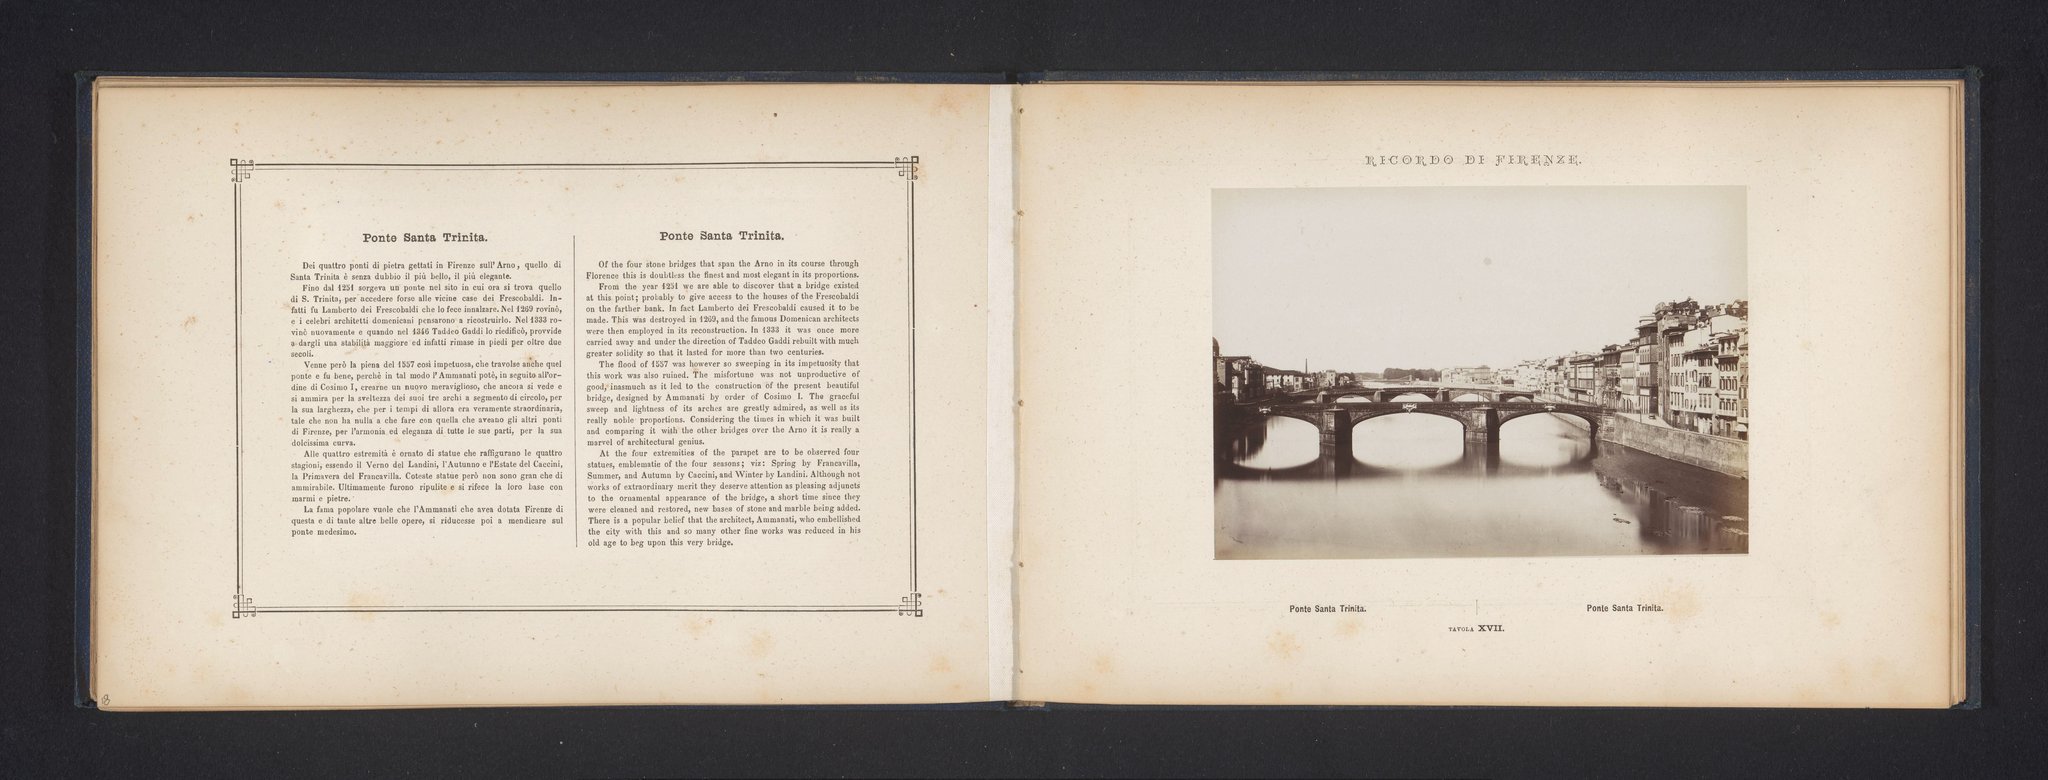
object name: photograph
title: Ricordo di Firenze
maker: giacomo brogi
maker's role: fotograaf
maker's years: 1822-1881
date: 1861-1871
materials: photographic support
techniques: albumen print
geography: florence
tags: bridge in city across river, canal, etc.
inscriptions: number: ‘Tavola XVII.’